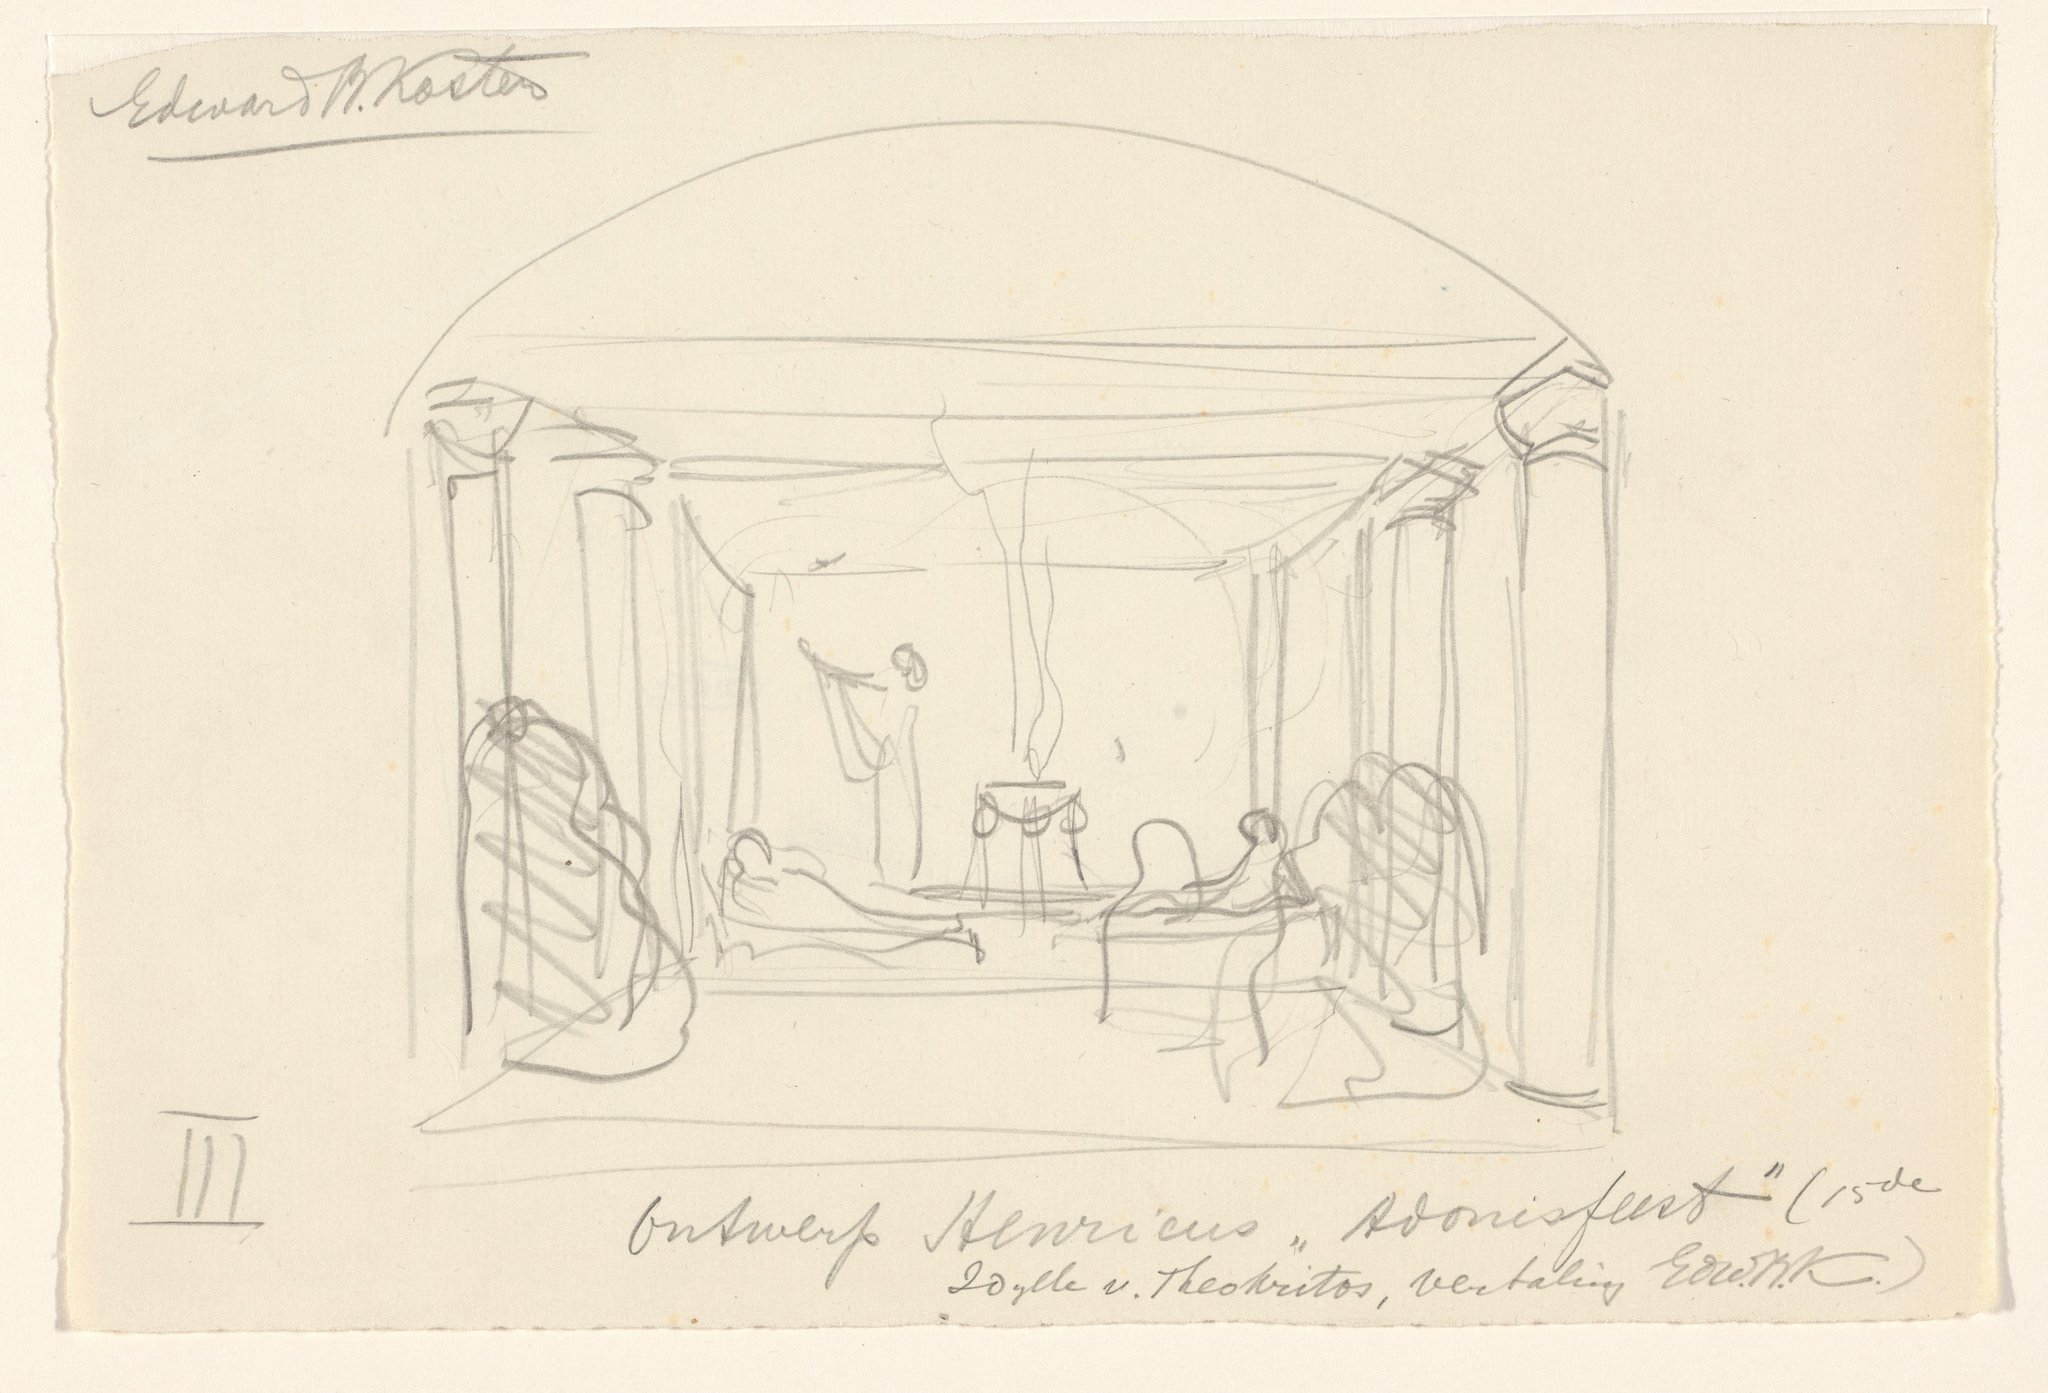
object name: drawing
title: Ontwerp voor een toneeldecor voor 'Het Adonisfeest, Vijftiende Idylle van Theokritos'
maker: henricus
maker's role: draughtsman, print maker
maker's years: 1867-1921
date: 1877-1921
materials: paper, pencil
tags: stage design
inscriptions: annotation: ‘II Ontwerp van Henricus "Adonisfeest" (15de/ Idylle v. Theokritos,/ vertaling Edw.B.K.)’, collector's mark: Lugt 2228a, annotation: ‘Edward B. Koster’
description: Zuilengalerij met een rookoffer en enkele figuren.